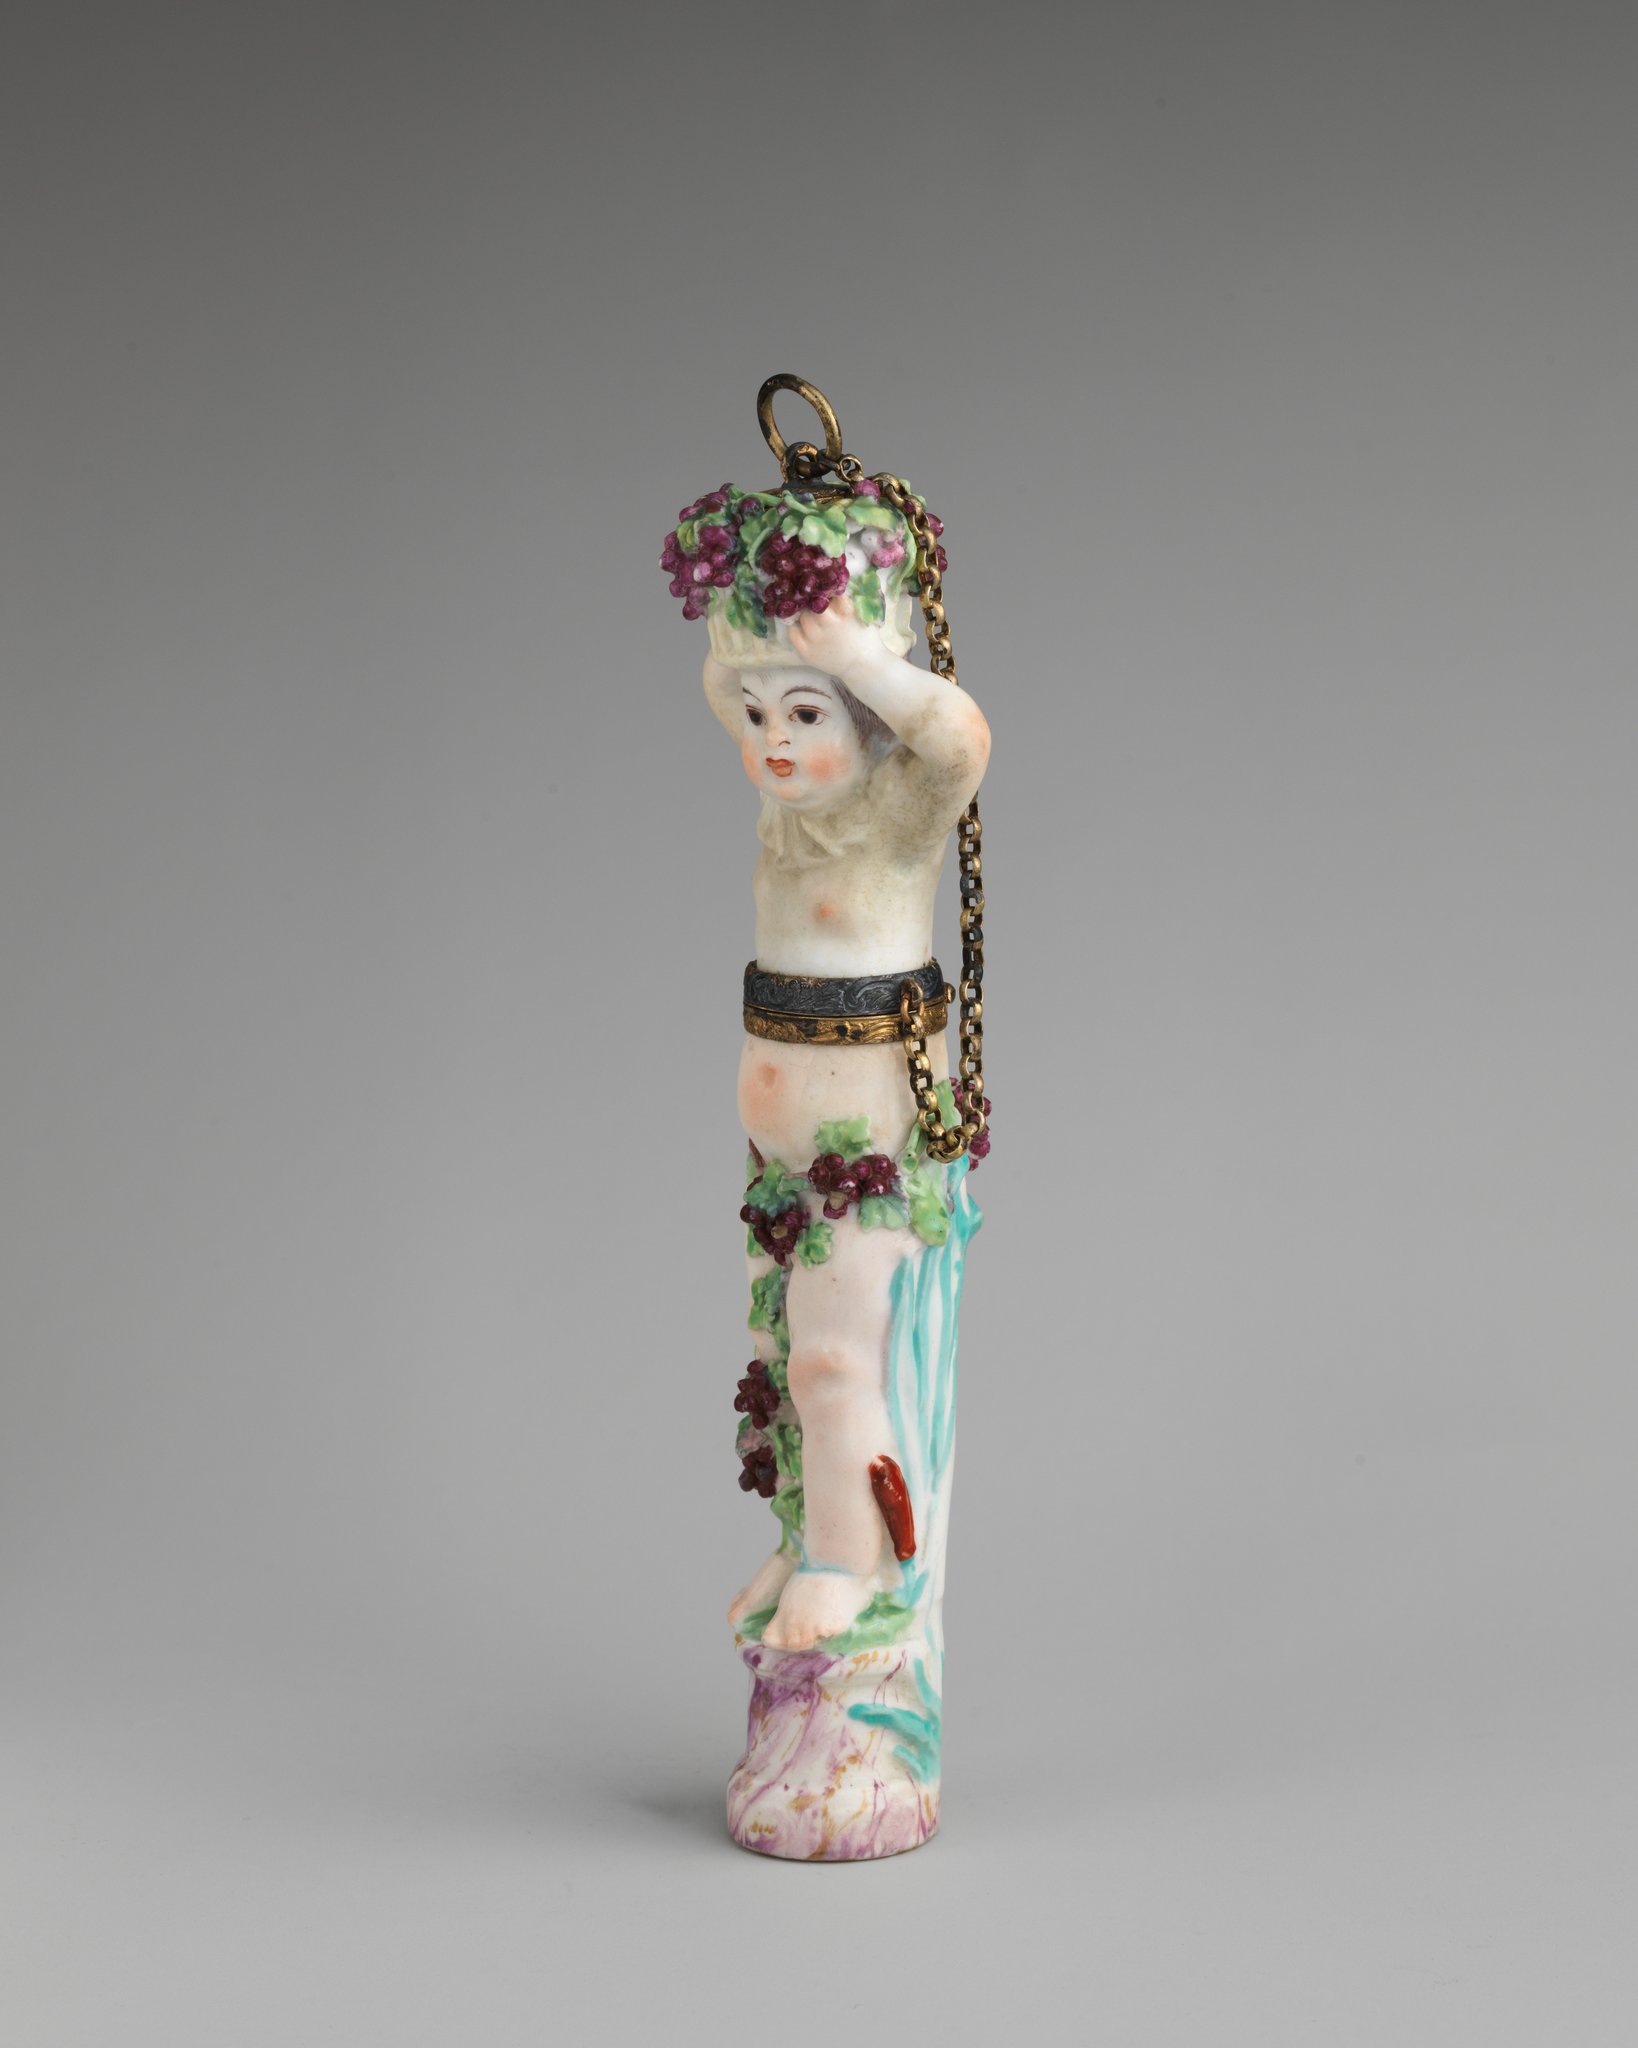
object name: toy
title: Infant Bacchus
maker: chelsea porcelain manufactory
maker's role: factory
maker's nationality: british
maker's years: 1744-1784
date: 1755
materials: soft paste porcelain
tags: grapes,infants